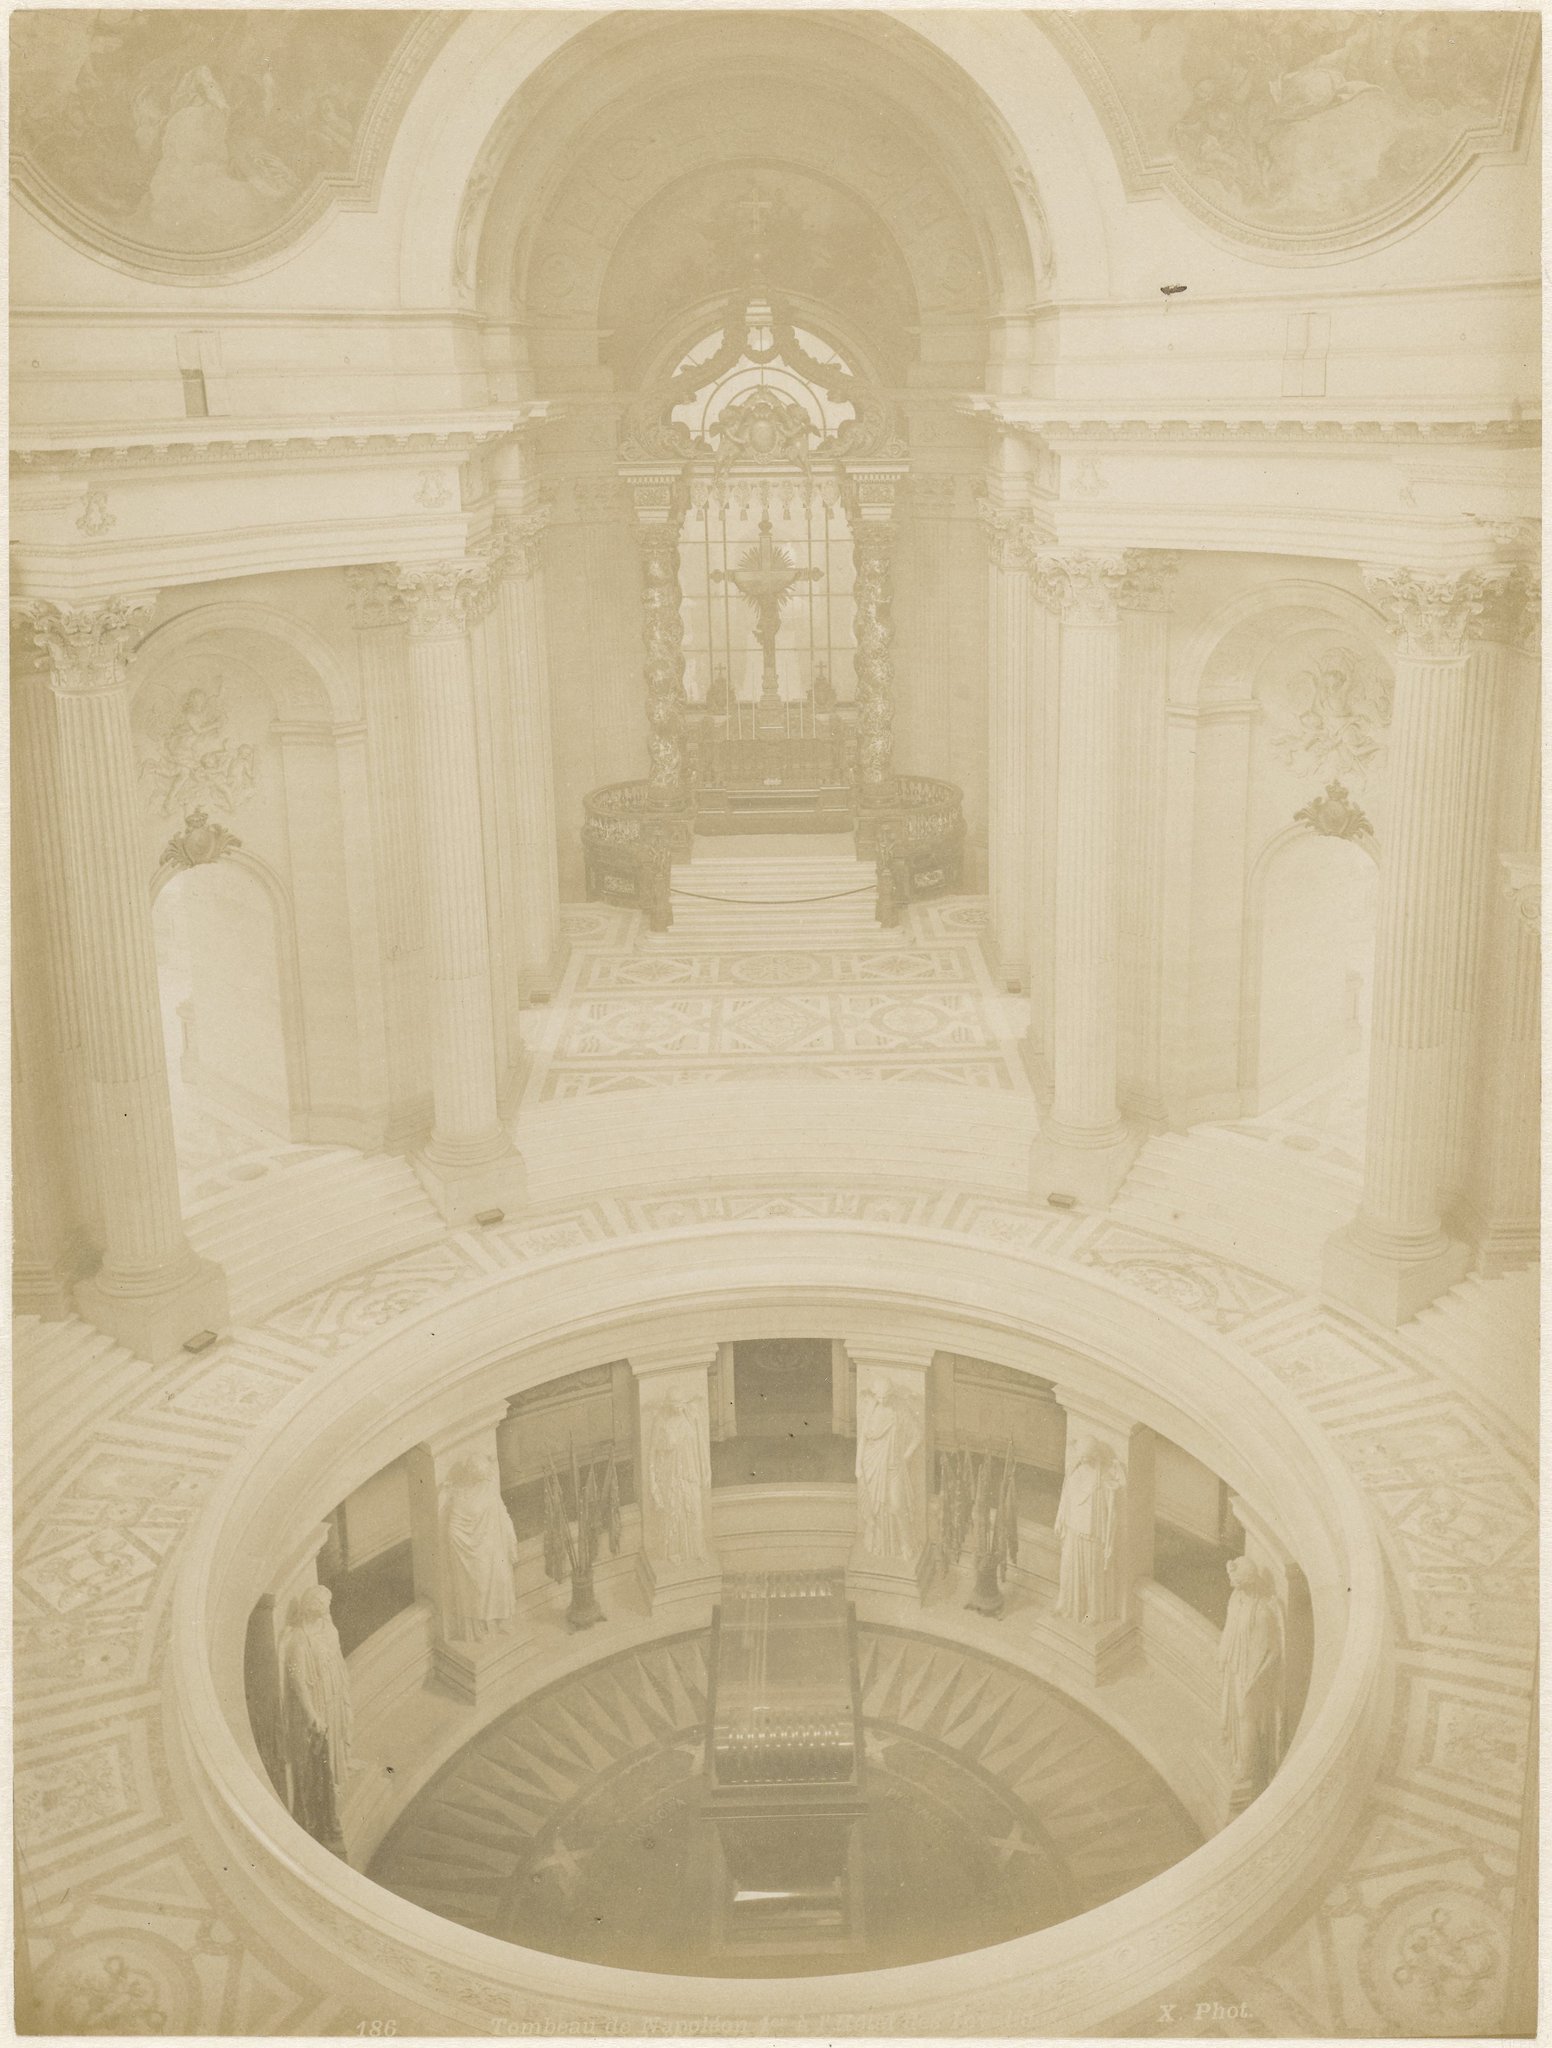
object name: photograph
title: Tombeau de Napoléon 1er à l'Hôtel des Invalides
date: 1887-1900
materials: paper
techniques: albumen print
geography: paris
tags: napoleon i (emperor of the french), grave, tomb, mausoleum, grave-building, monumental tomb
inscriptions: inscription: ‘186 Tombeau de Napoléon 1er à l'Hôtel des Invalides X. Phot.’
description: Tussen 1887 en ca. 1900 werkten Neurdein frères onder andere onder de naam 'X phot.'.